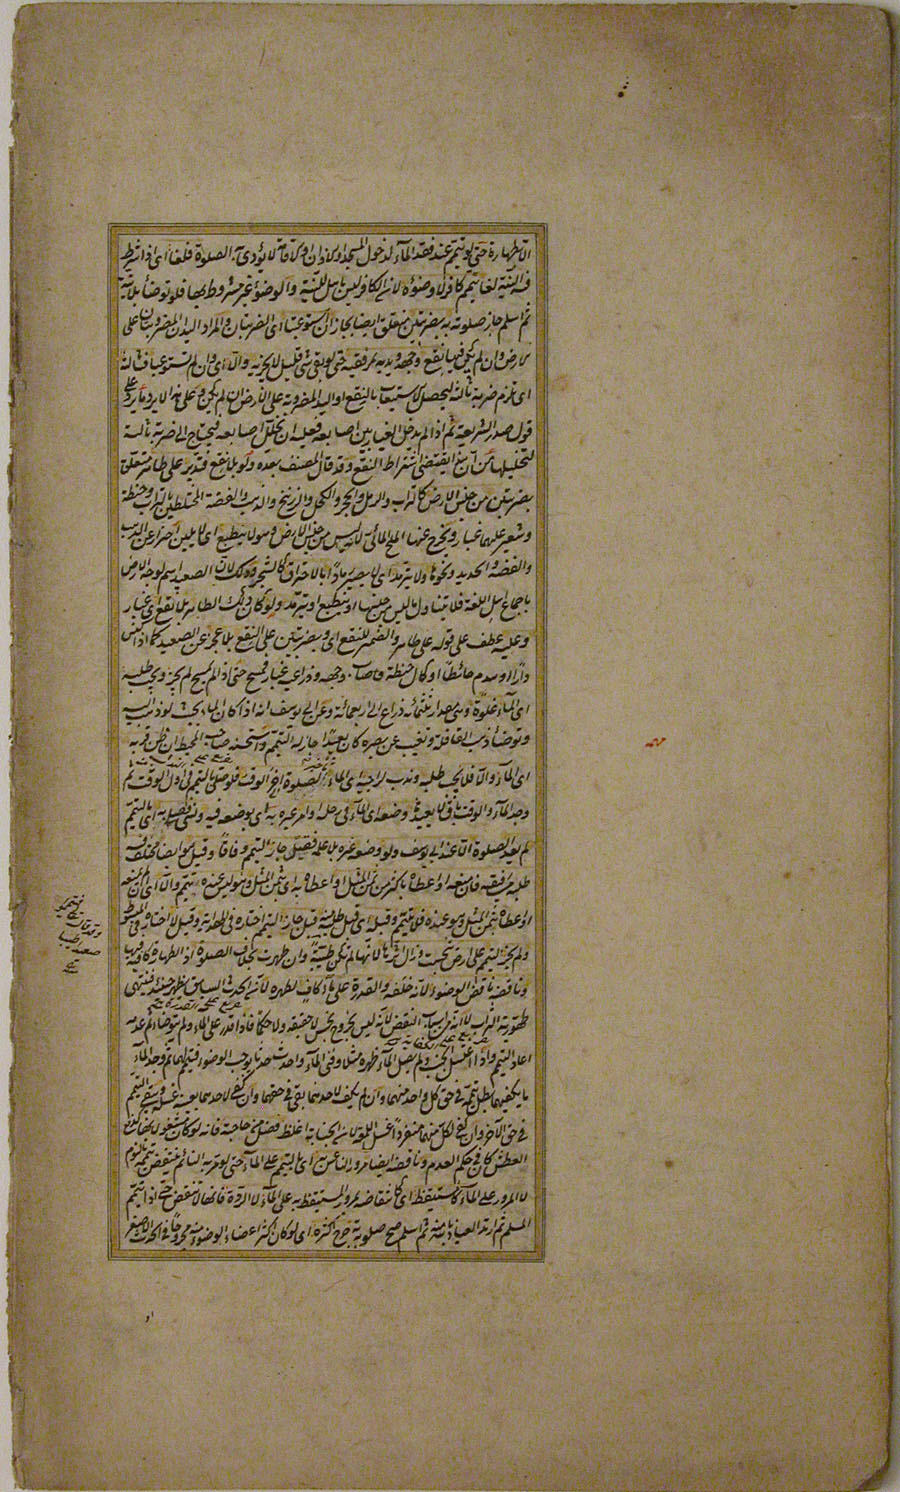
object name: folio from a non illustrated manuscript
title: Treatise of Jurisprudence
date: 1467-1600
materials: gold, ink, paper, watercolor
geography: syria